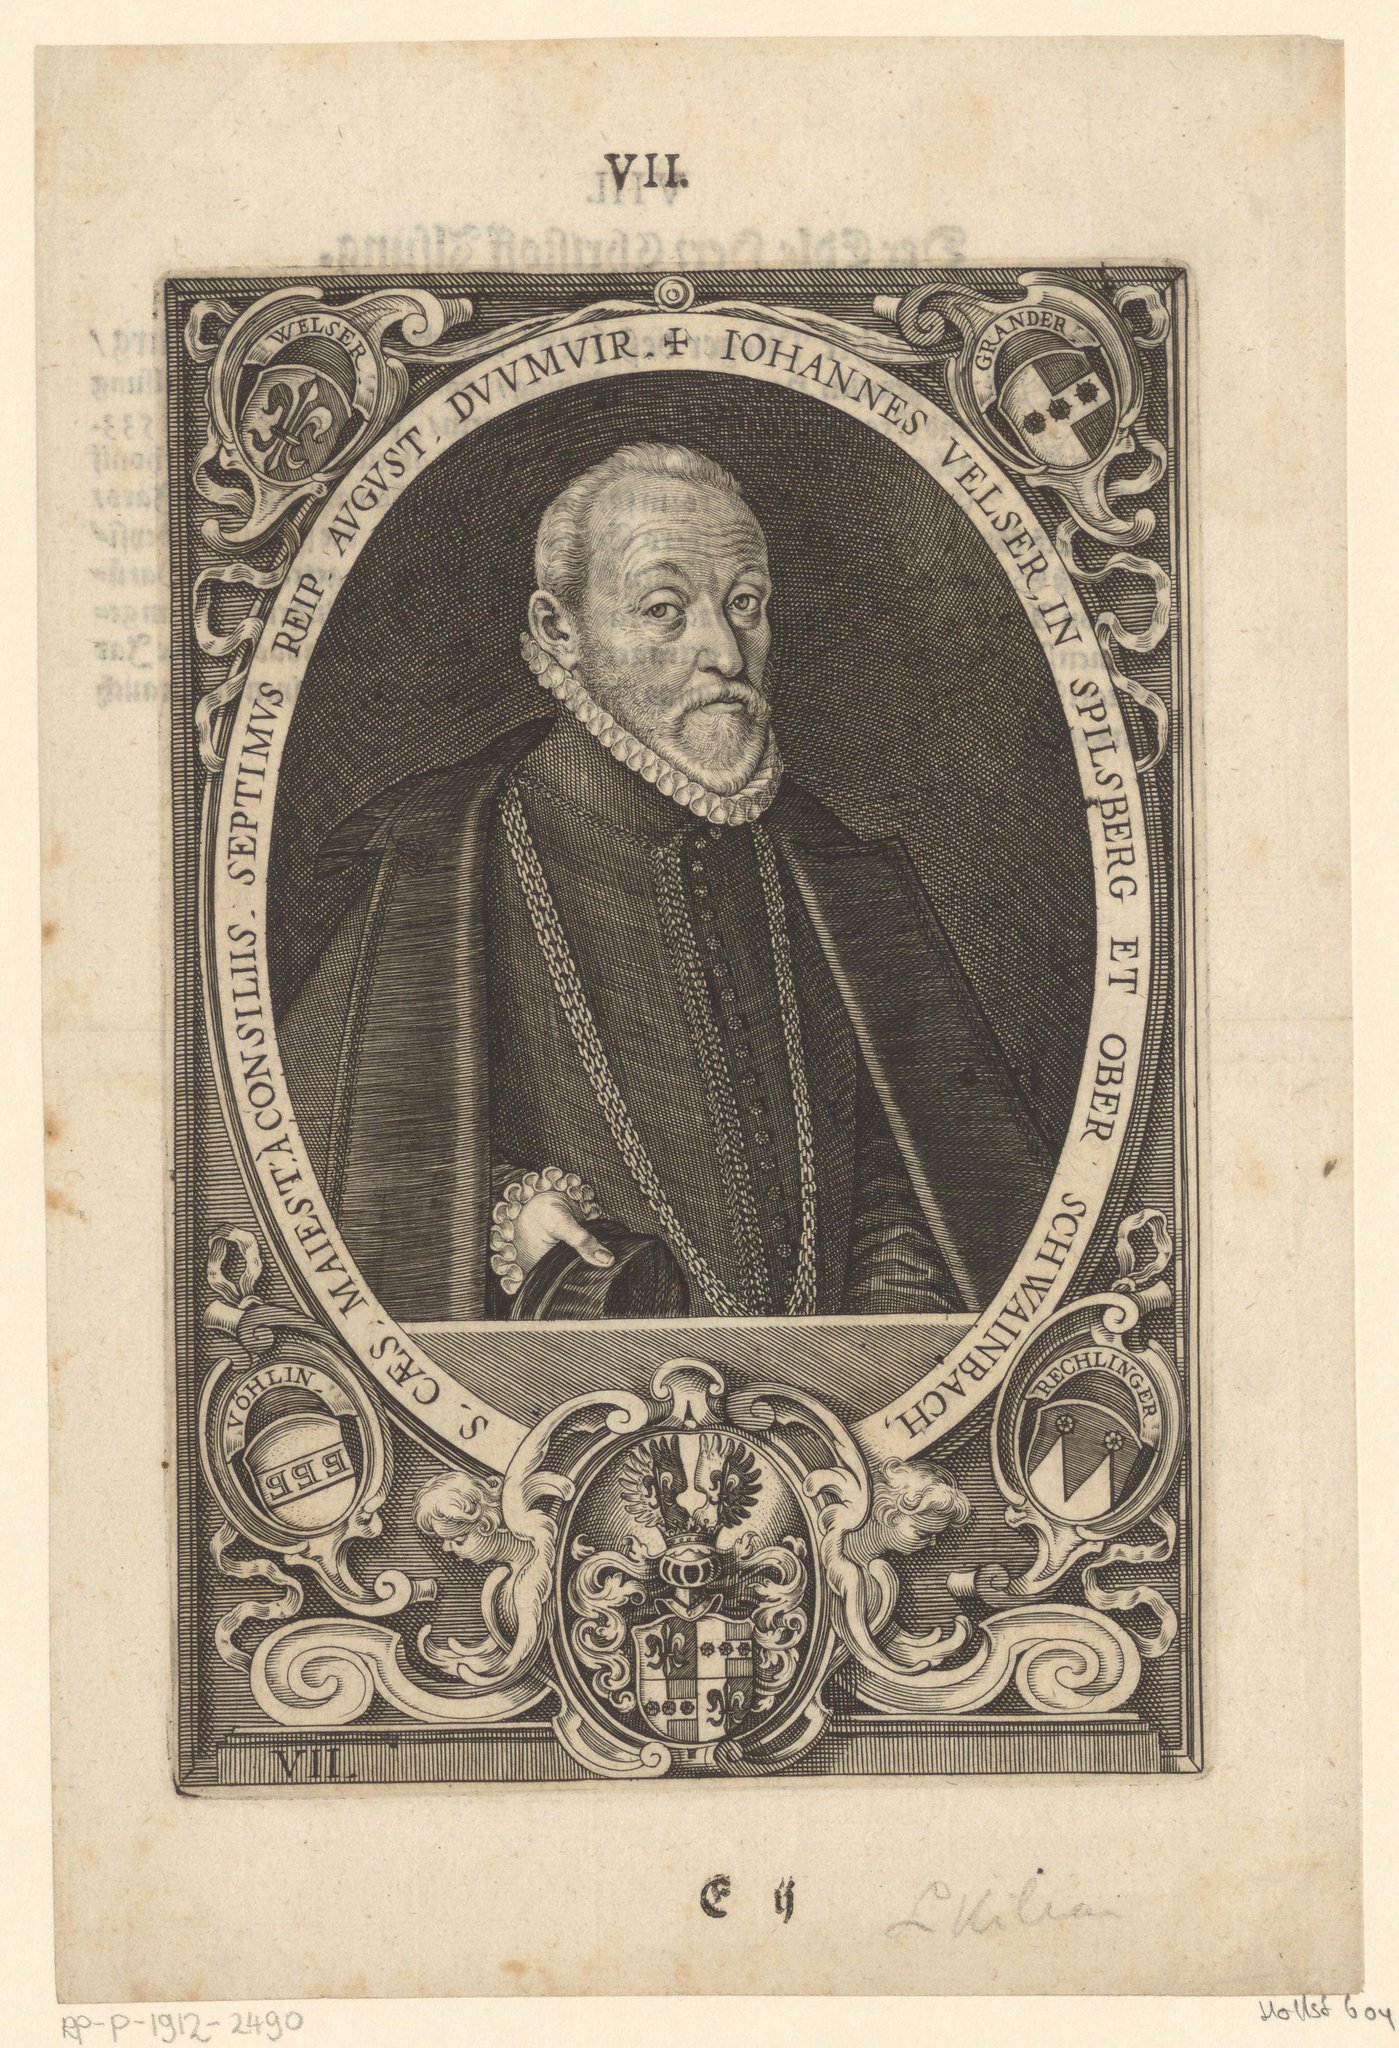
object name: print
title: Portret van Johann Welser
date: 1615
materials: paper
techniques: engraving, etching, letterpress printing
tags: mayor, coat of arms (as symbol of the state, etc.), historical persons, counsellor, merchant, salesman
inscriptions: collector's mark: Lugt 2228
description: Deze prent is oorspronkelijk ontworpen voor: Kilian, Lucas. Imp. Caes. Caroli V.S.A. Decreto et auspiciis (...) formis expressi MDCXXIV. Augsburg: Lucas Kilian, 1624. De prent komt uit een publicatie die is samengesteld door Johann Michael Roth en is rond 1700 voor het eerst uitgegeven in Augsburg onder de titel ‘Wahrhaffte Bildnüsse aller des Heil: Röm: Reichs Freyen Stadt Augspurg, Herren Stadt-Pfleger’. Hierin heeft een prent 1755 als datum, waar de datering van deze prent op is gebaseerd. De laatste editie van dit boek is in 1806 verschenen.